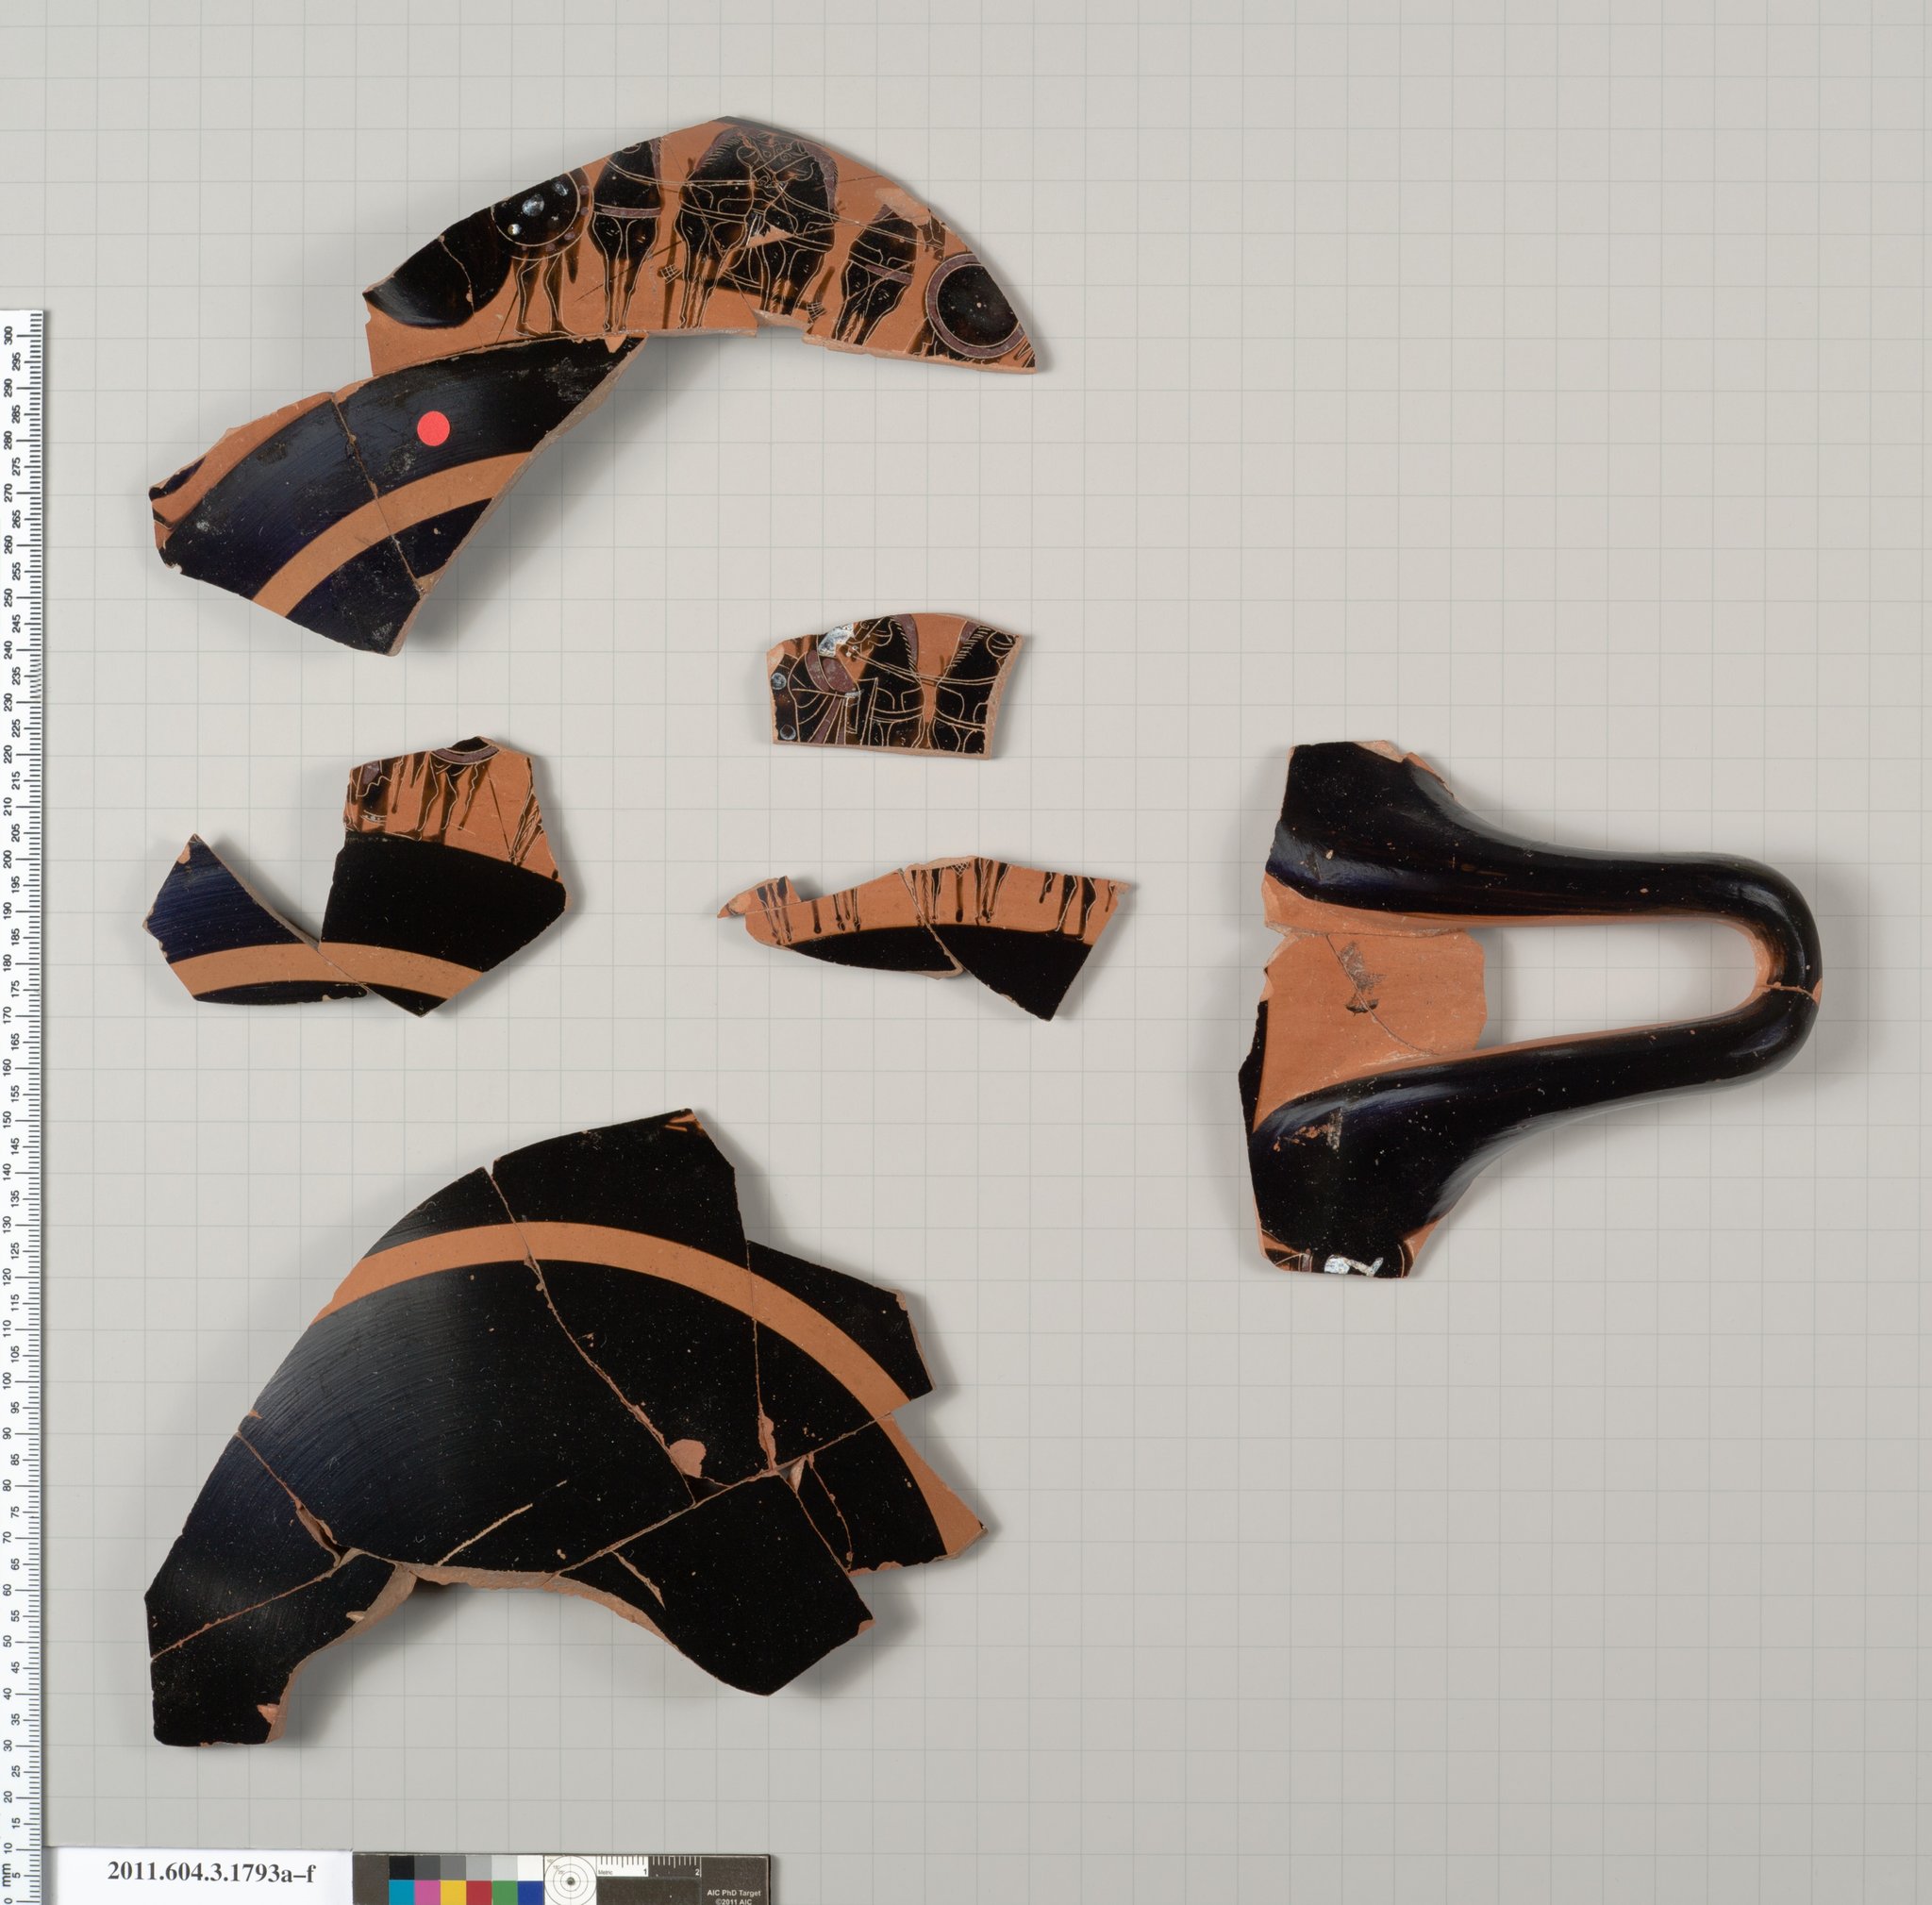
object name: kylix fragment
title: Terracotta fragments of a kylix: Band cup (drinking cup)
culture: greek, attic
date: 560-540 BCE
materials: terracotta